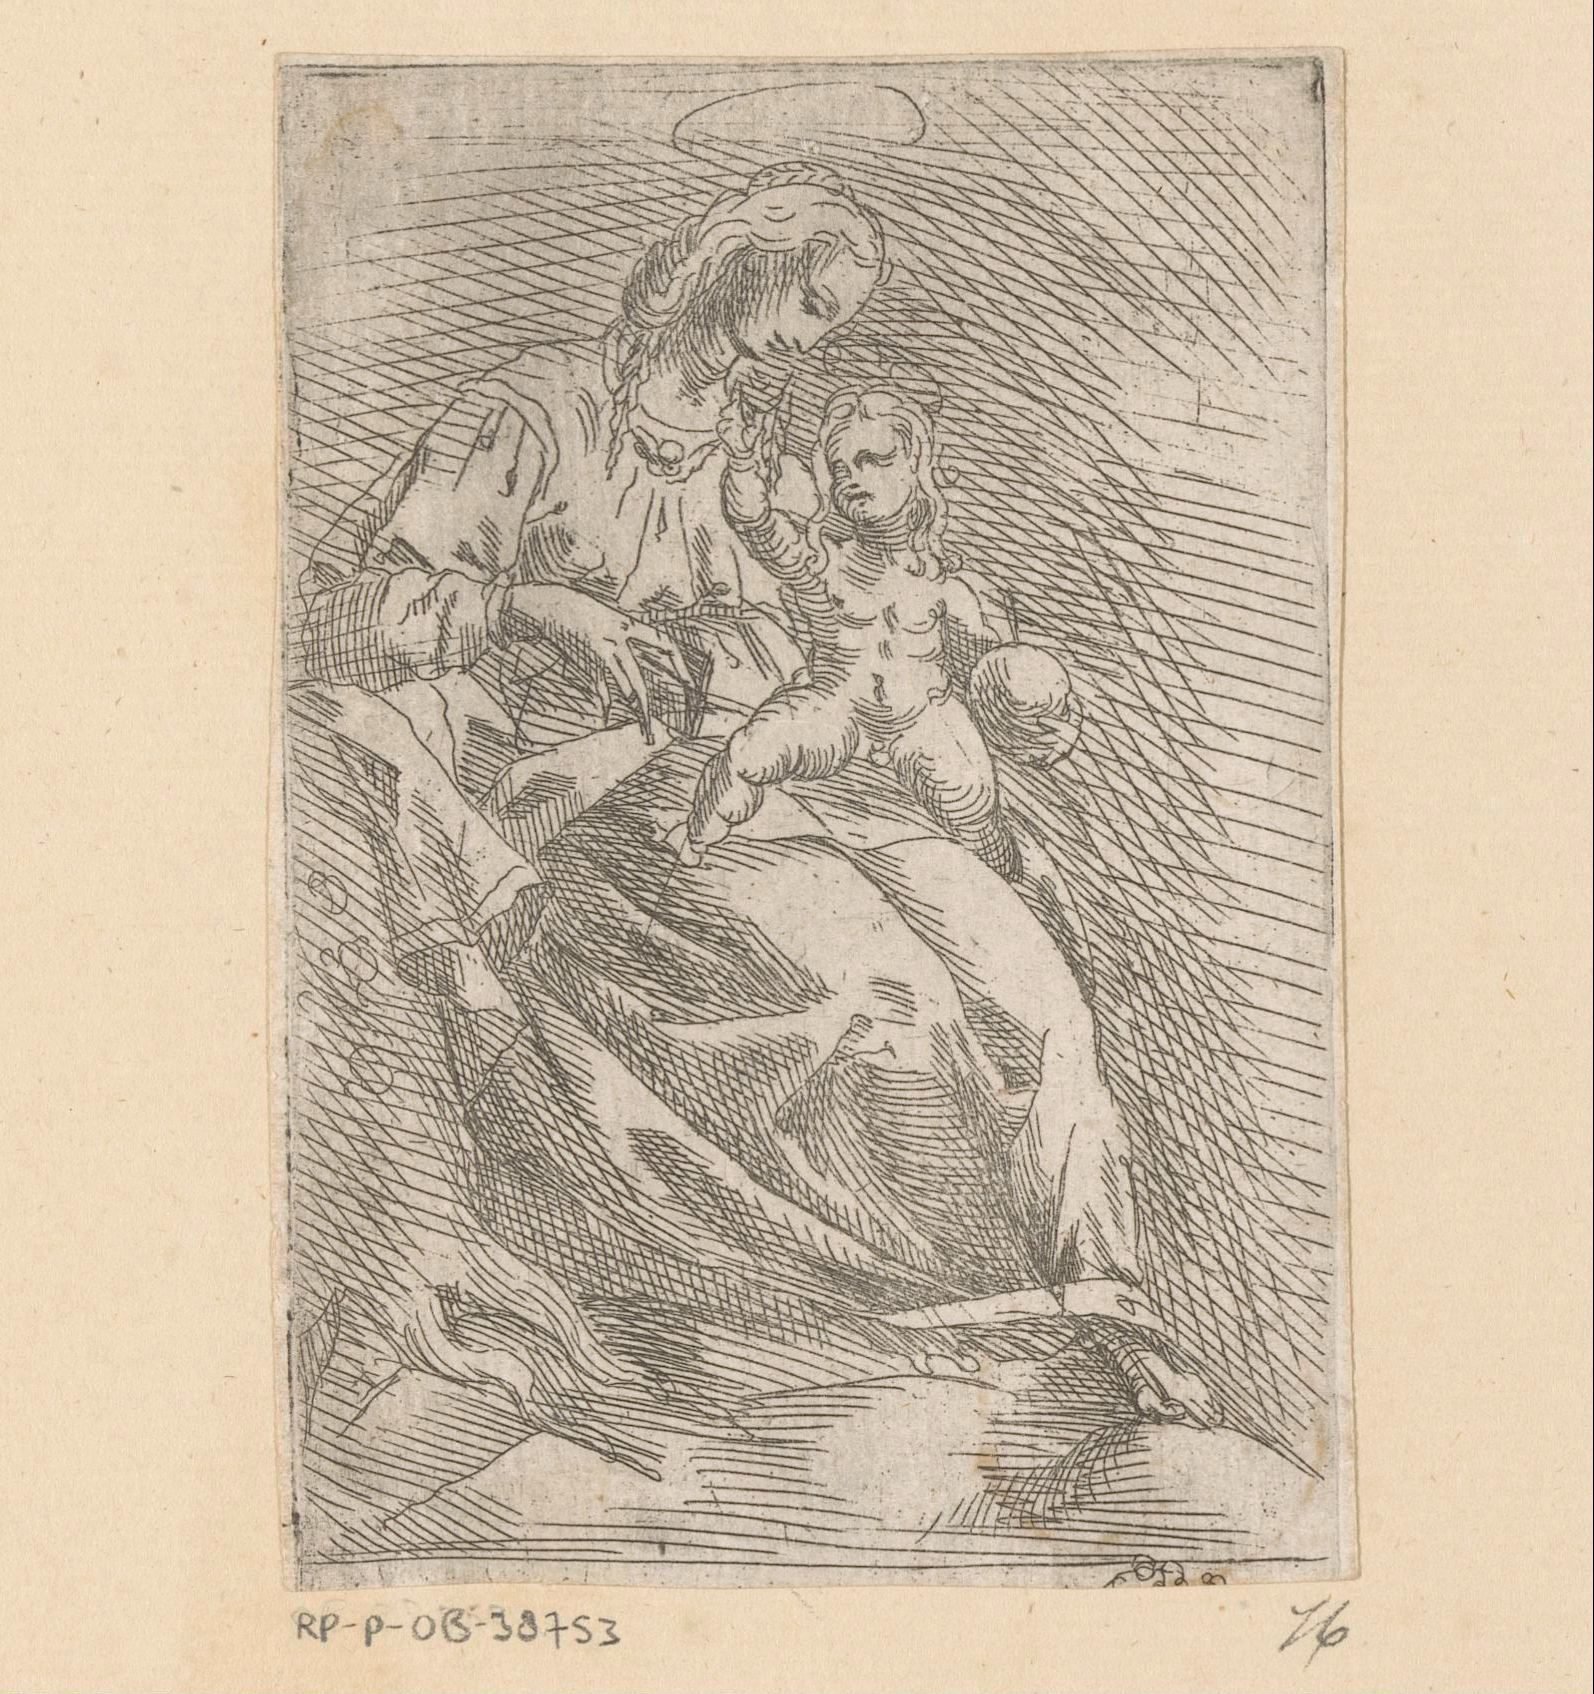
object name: print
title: Maria met Kind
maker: Anonymous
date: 1600-1699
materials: paper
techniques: etching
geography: italy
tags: madonna: i.e. mary with the christ-child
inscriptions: collector's mark: Lugt 240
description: Maria met het Christuskind op schoot. In zijn hand houdt Christus de rijksappel.